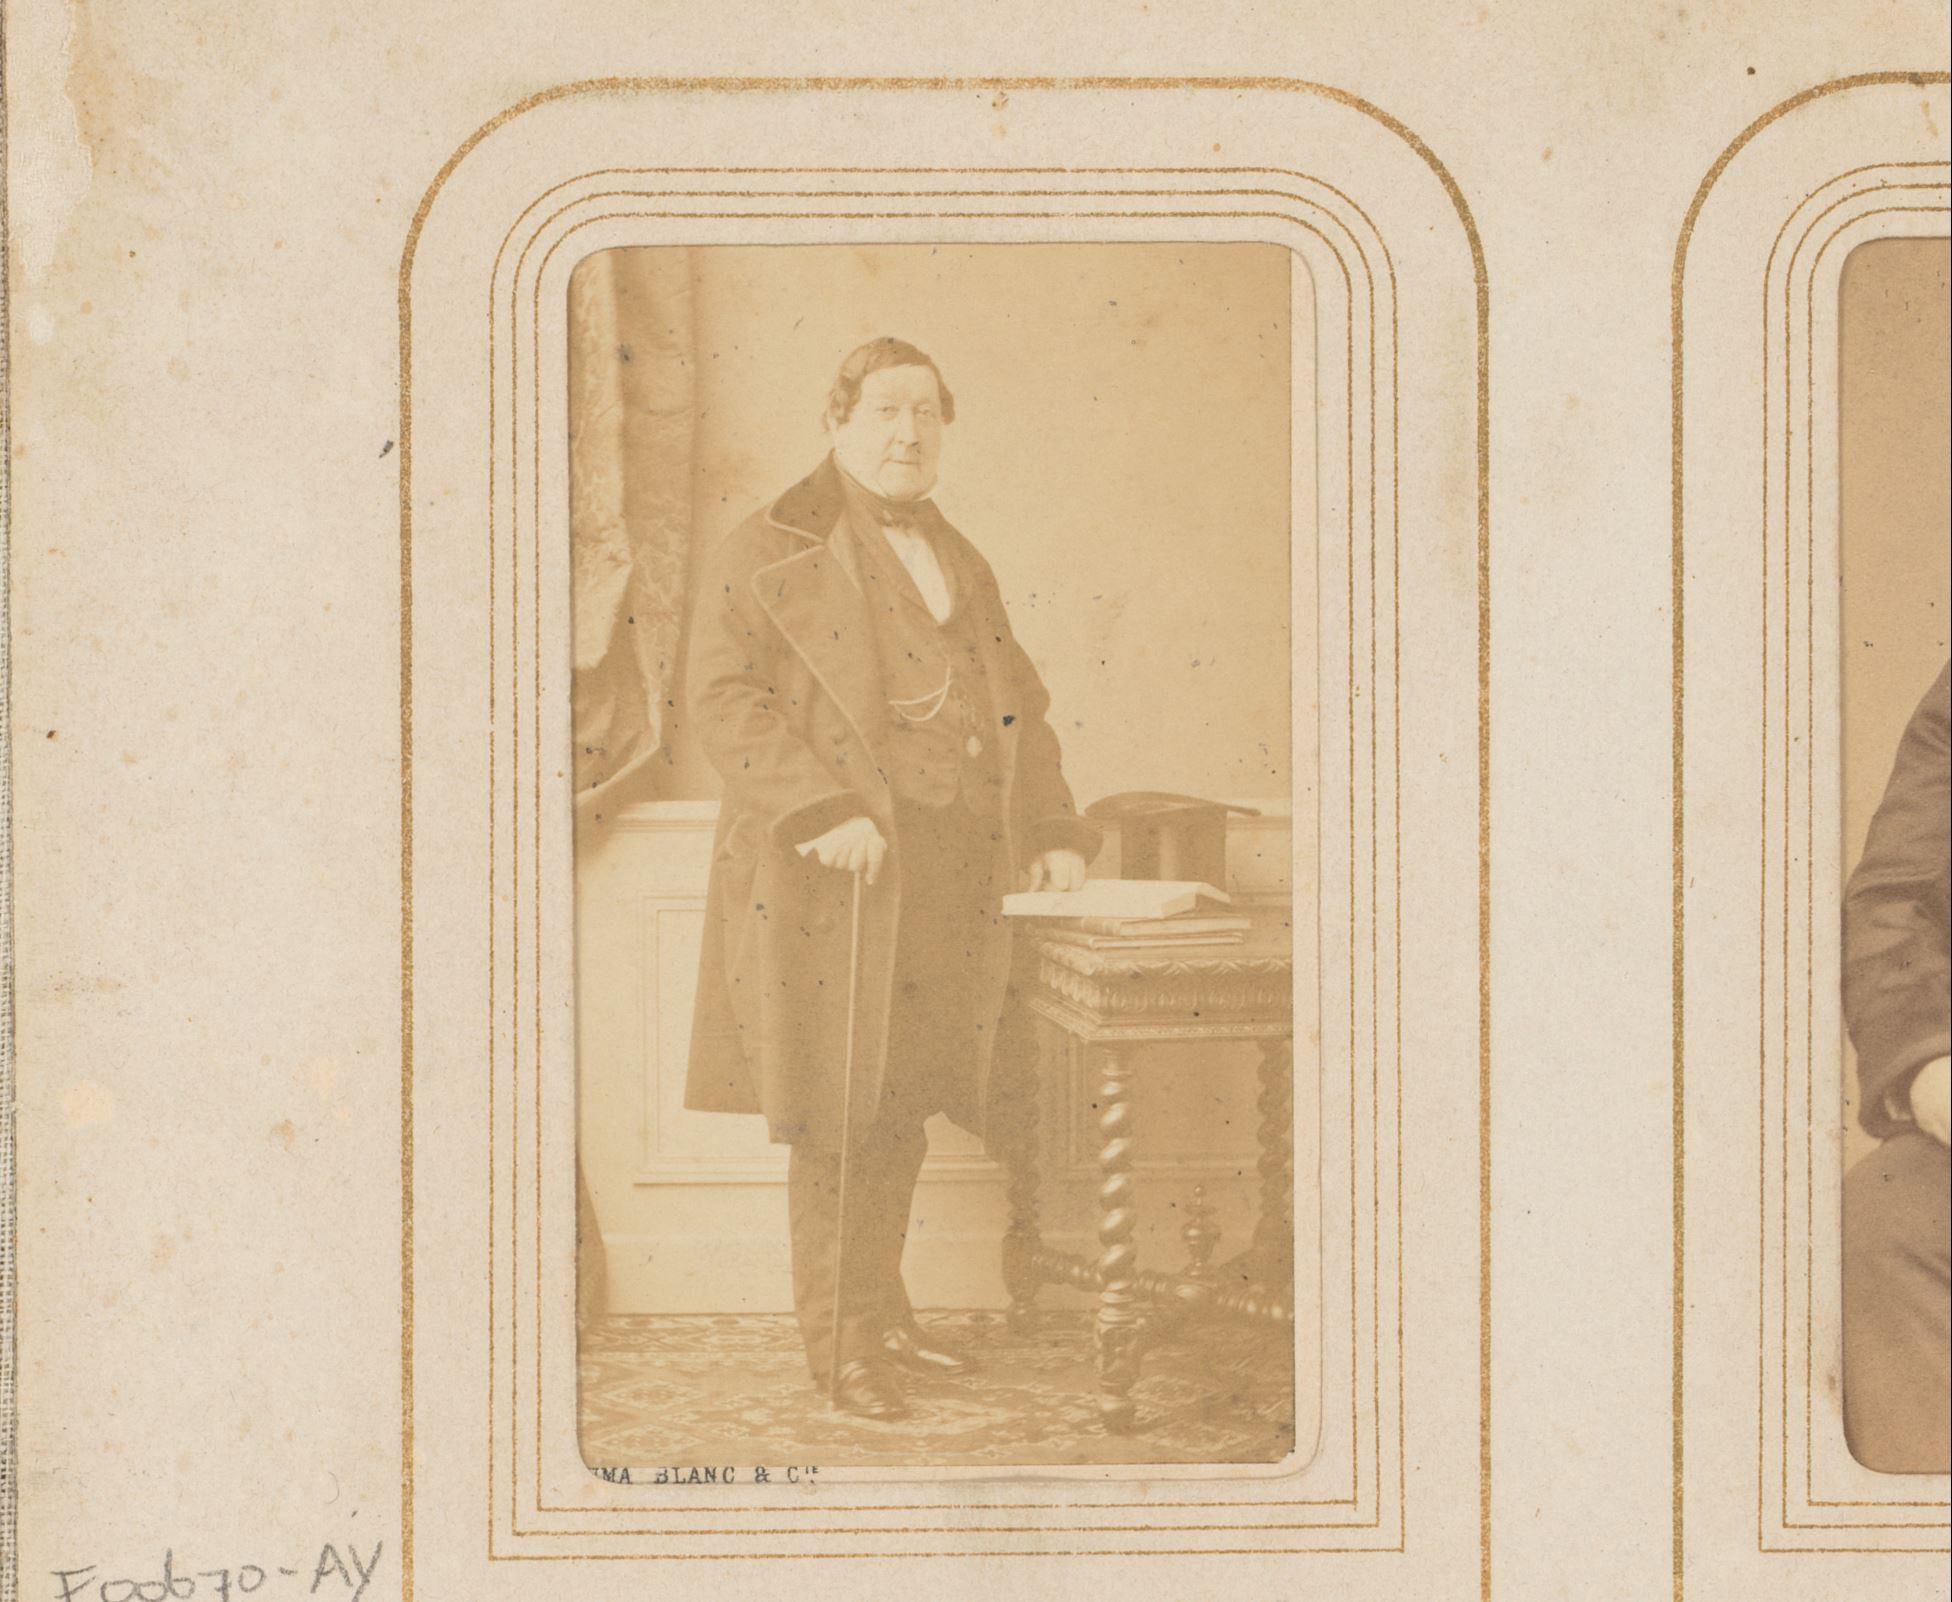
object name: album leaf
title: Portret van Gioacchino Antonio Rossini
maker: numa blanc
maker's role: publisher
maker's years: 1816-1897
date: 1855-1868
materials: cardboard, photographic support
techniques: albumen print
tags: gioacchino antonio rossini, historical persons, portrait of composer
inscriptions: annotation: ‘Gioacchino Antonio Rossini/ ital componist 1792-1868 (Numa Blanc)’, inscription: ‘Collé & Vérane/ Rue st. Ferréol, 14/ Marseille’, name: ‘Rossini’